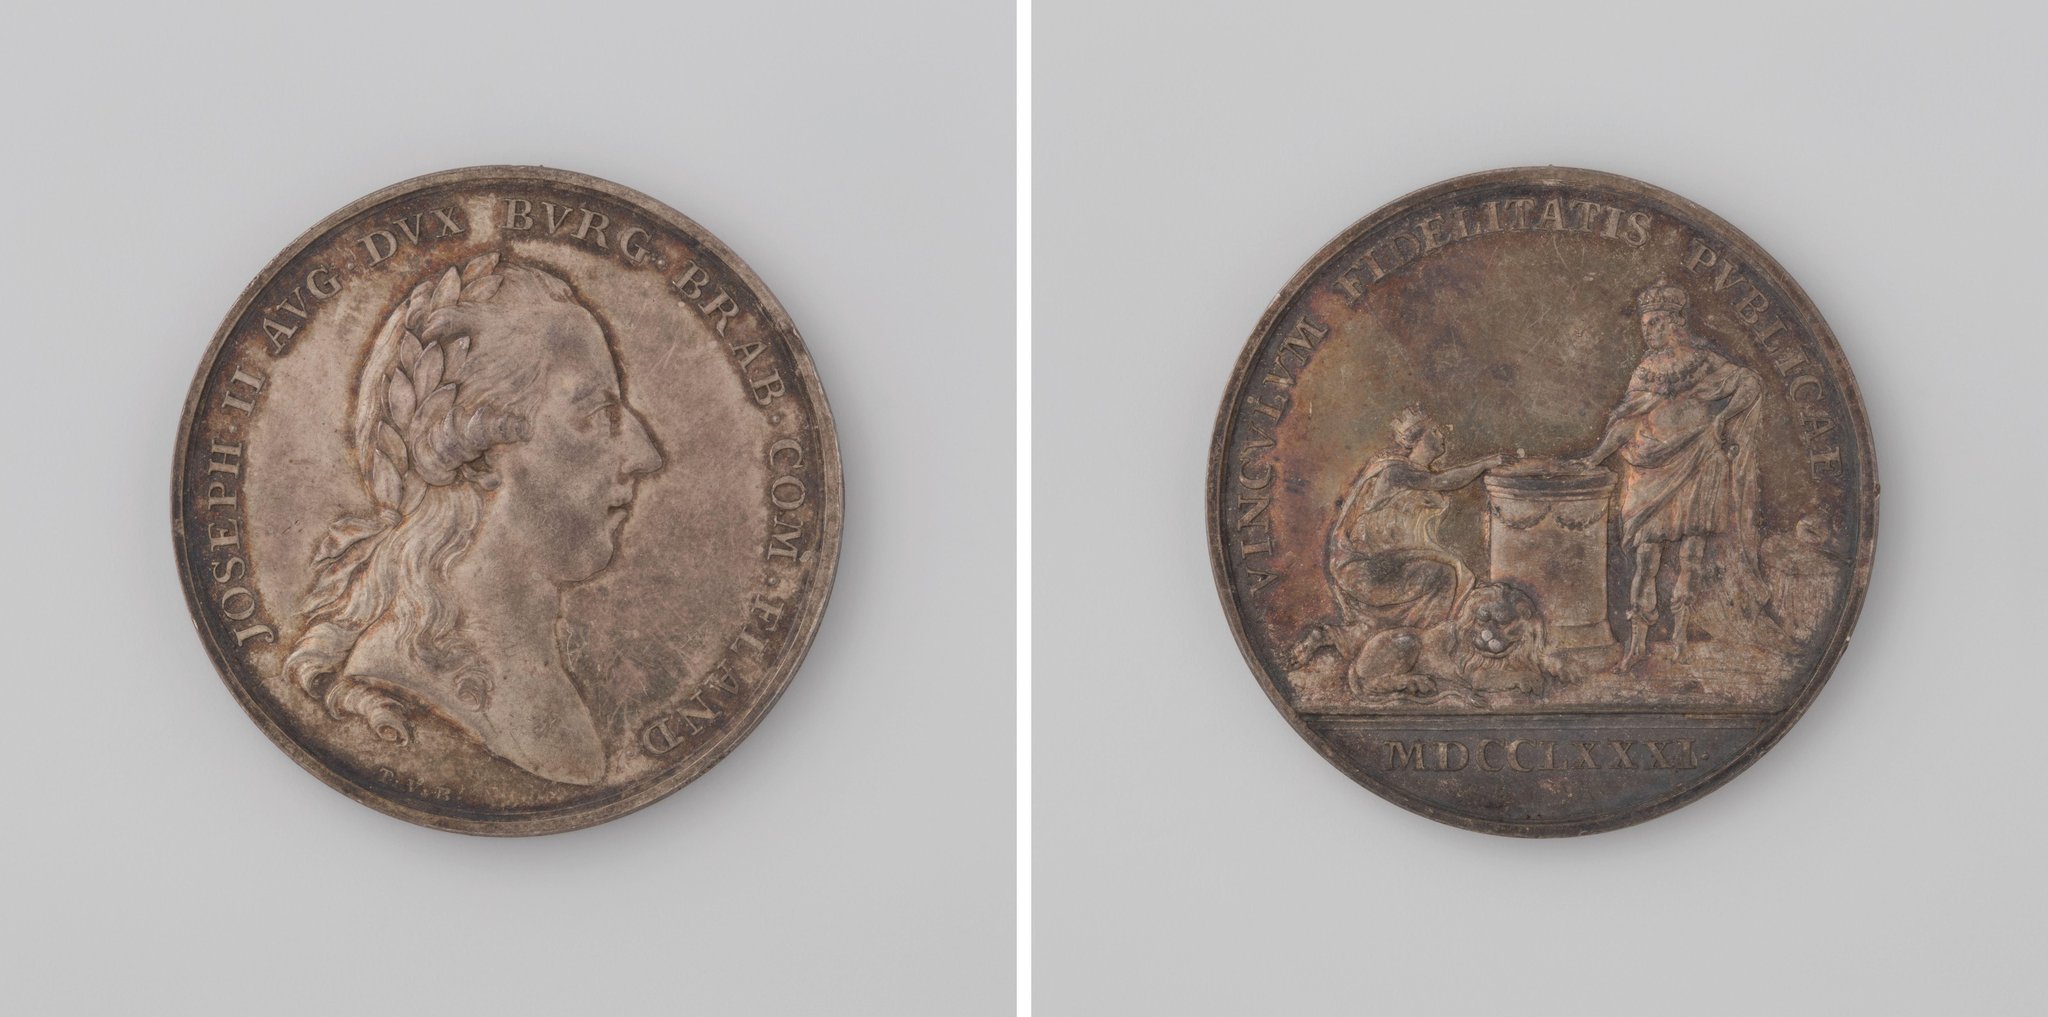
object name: history medal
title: Inhuldiging van Jozef II, Duits keizer als hertog van Brabant en graaf van Vlaanderen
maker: theodorus victor van berckel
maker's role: mintmaster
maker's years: 1739-1808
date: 1781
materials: silver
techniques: striking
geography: brussels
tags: jozef ii (duits keizer), brabant